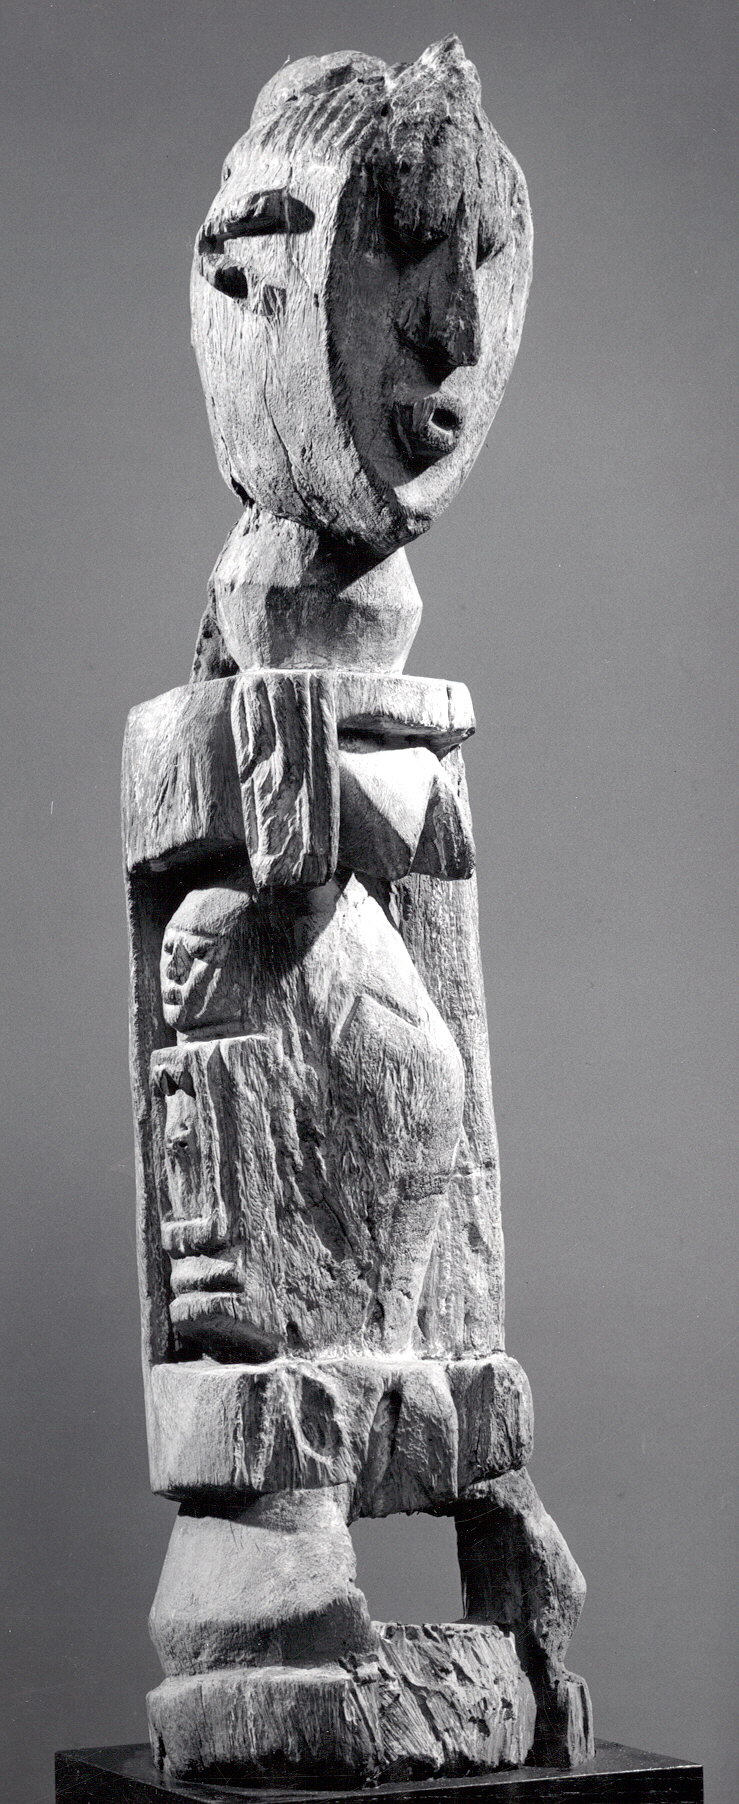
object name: figure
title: Figure: Female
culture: dogon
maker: dogon blacksmith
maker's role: artist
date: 1401-1900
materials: pigment, wood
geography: mali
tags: women